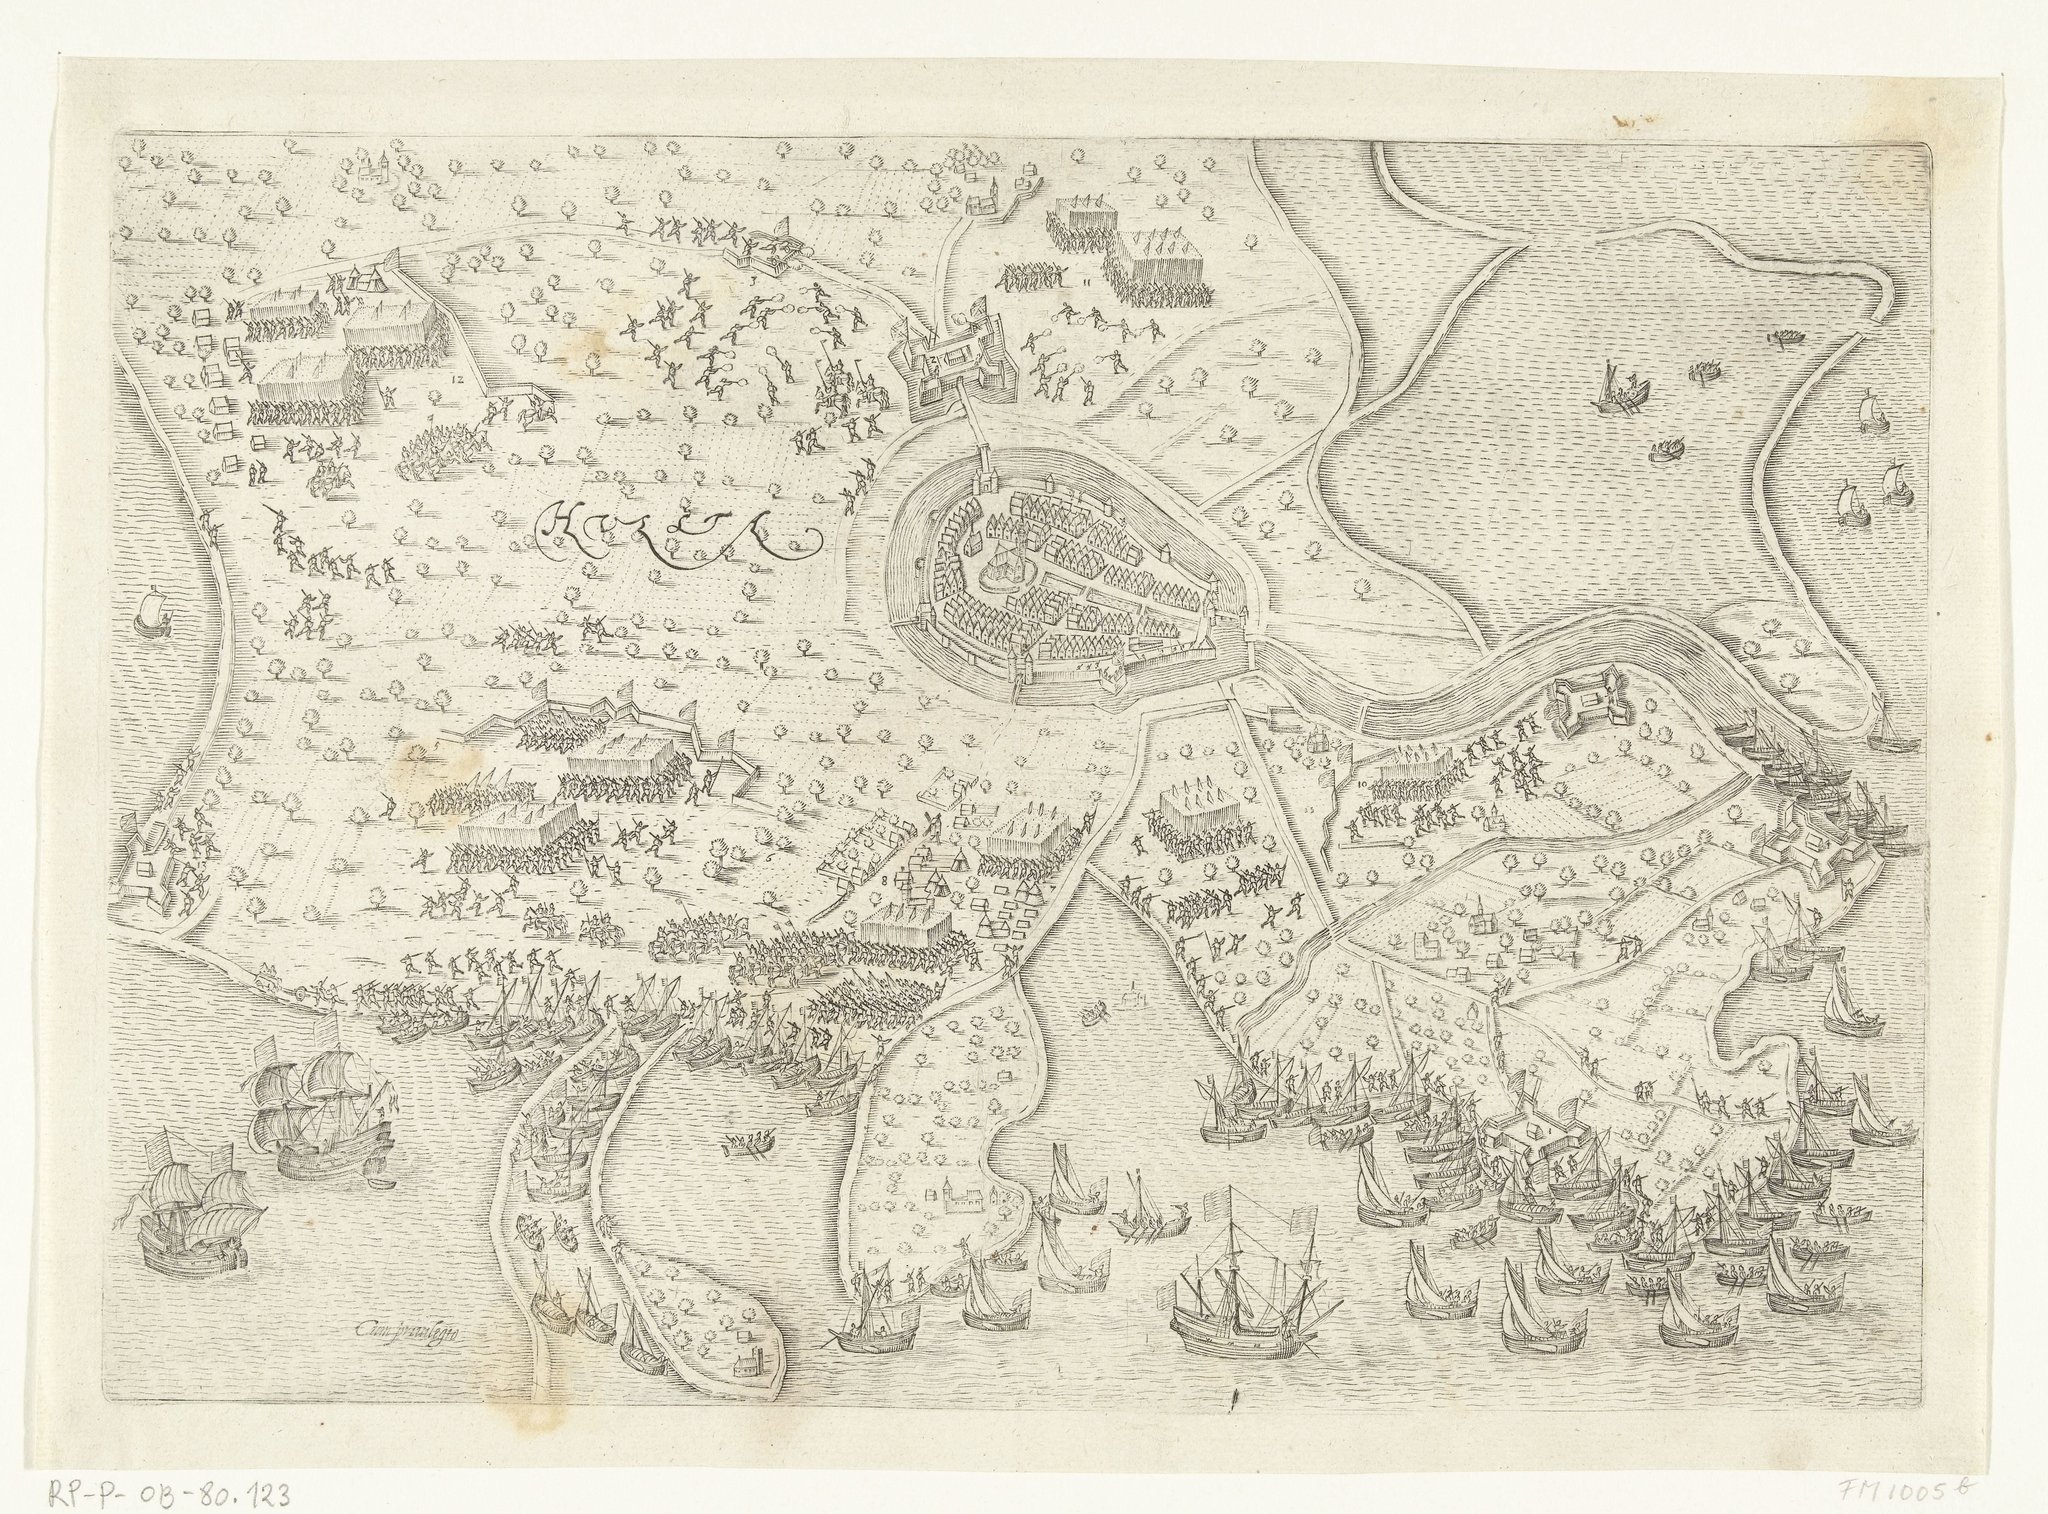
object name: print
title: Beleg en inname van Hulst door Maurits, 1591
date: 1600-1601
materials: paper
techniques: engraving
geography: northern netherlands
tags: the hague, maurice (prince of orange), siege, position war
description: Gebruikt als illustratie in: J.J. Orlers, De oorlochs-daden vanden doorlichtigen vorst Mavrits van Nassav. Of den nievven vermeerden Nassavschen lauren-crans: Warachtige beschrijvinghe van alle de belegeringhen ende victorien, te water ende te lande. Die God almachich[!], tot welvaren der Vereenichde Nederlanden te wege gebracht ende gegeven heeft, J.J. Orlers en H. van Haestens, Leiden 1619, p. 128